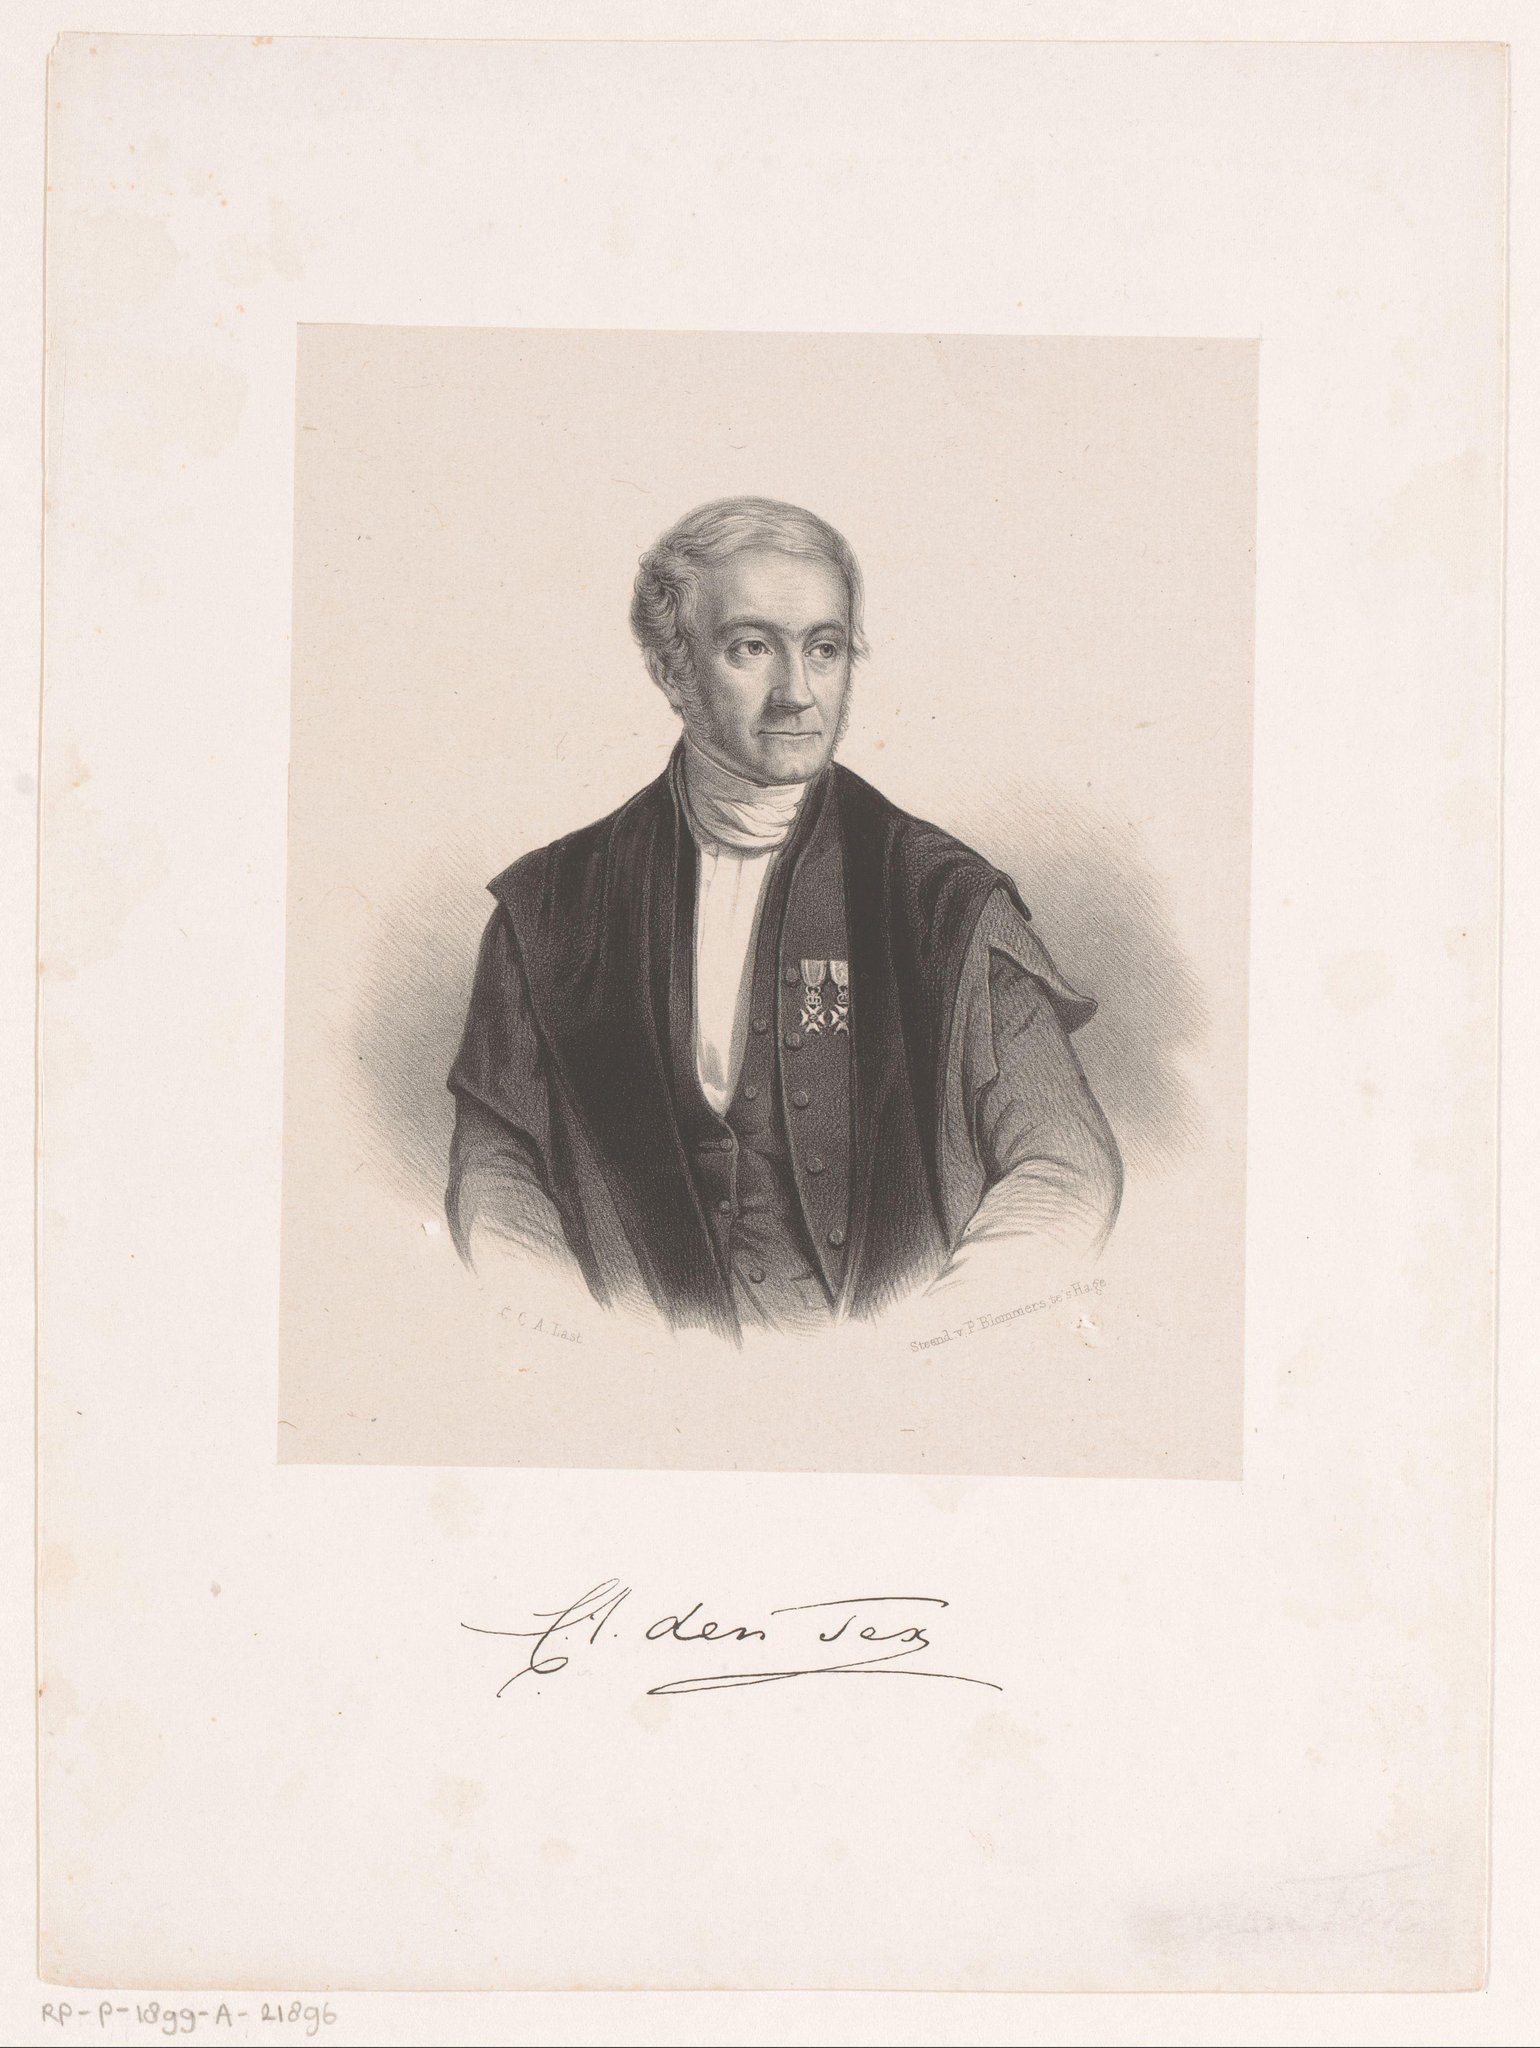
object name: print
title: Portret van Cornelis Anne den Tex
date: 1843-1876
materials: paper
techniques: tone lithography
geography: the hague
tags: amsterdam, knighthood order, historical persons (+ (full) bust portrait)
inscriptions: collector's mark: Lugt 2228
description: De geportretteerde draagt twee ridderorden op zijn borst. Onder het portret zijn signatuur.